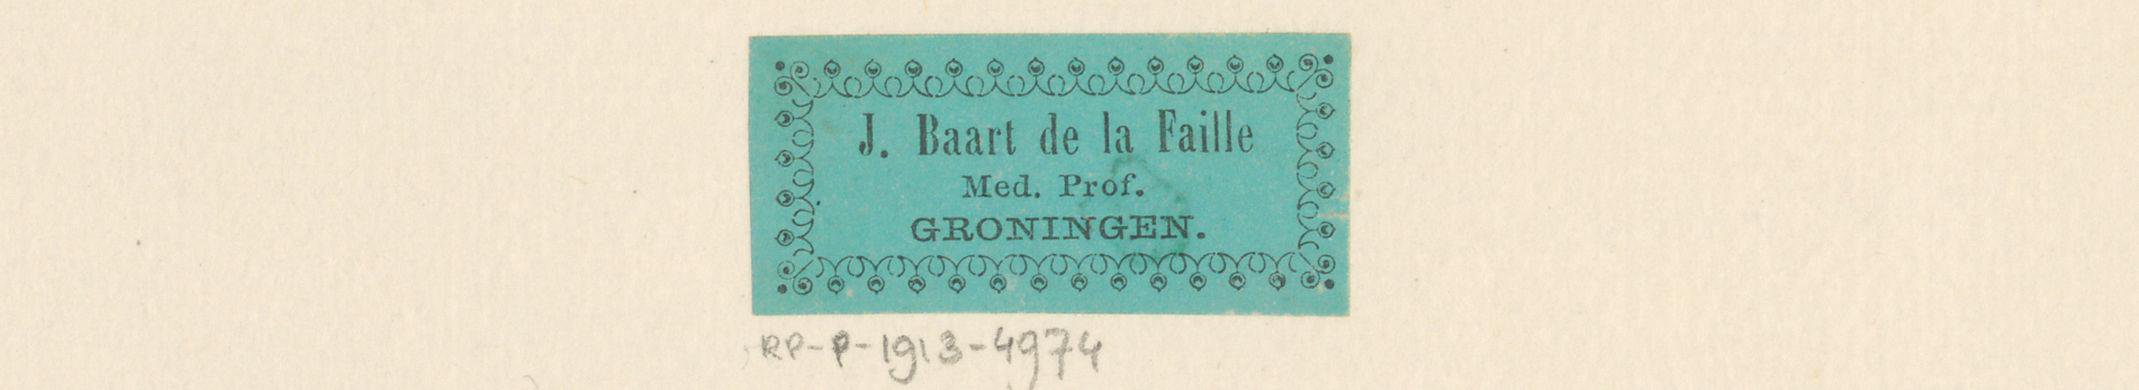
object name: bookplate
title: Ex libris van J. Baart de la Faille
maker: Anonymous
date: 1890-1913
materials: paper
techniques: printing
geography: netherlands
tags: jacob iv baart de la faille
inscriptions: collector's mark: Lugt 2233, collector's mark: Lugt 2760